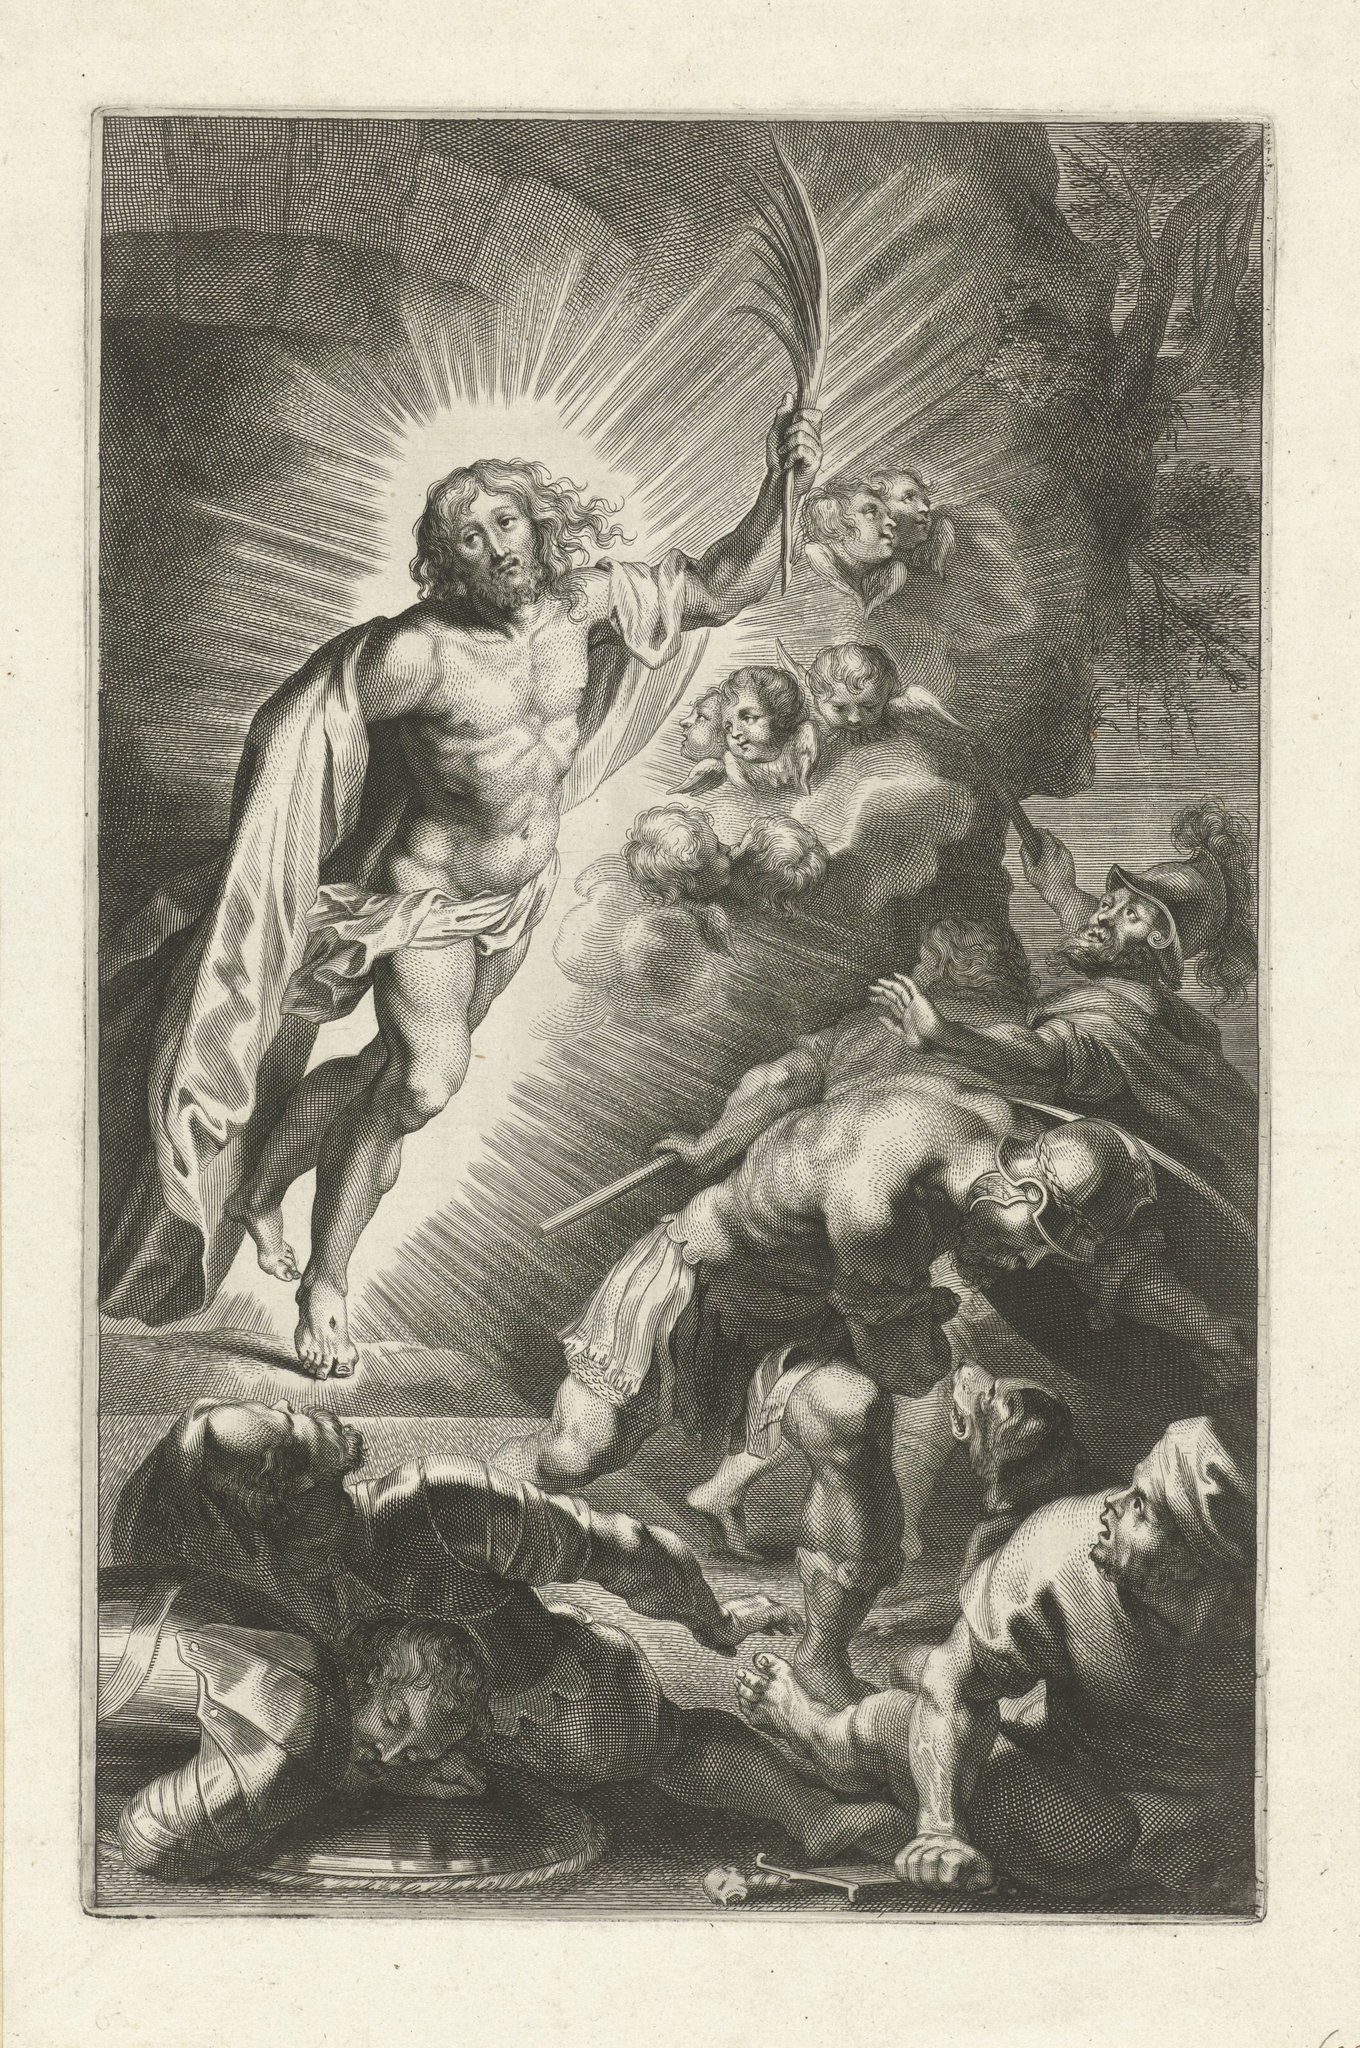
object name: print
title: Breviarium romanum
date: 1612-1616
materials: paper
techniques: engraving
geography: antwerp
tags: christ, usually holding a banner, arises from the grave; often combined with sleeping and/or frightened soldiers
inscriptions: collector's mark: Lugt 240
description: Christus verrijst uit zijn graf. Rondom hem engelen. De slapende soldaten schrikken wakker en slaan op de vlucht. De prent is deel van een serie met scènes uit het Oude en Nieuwe Testament.